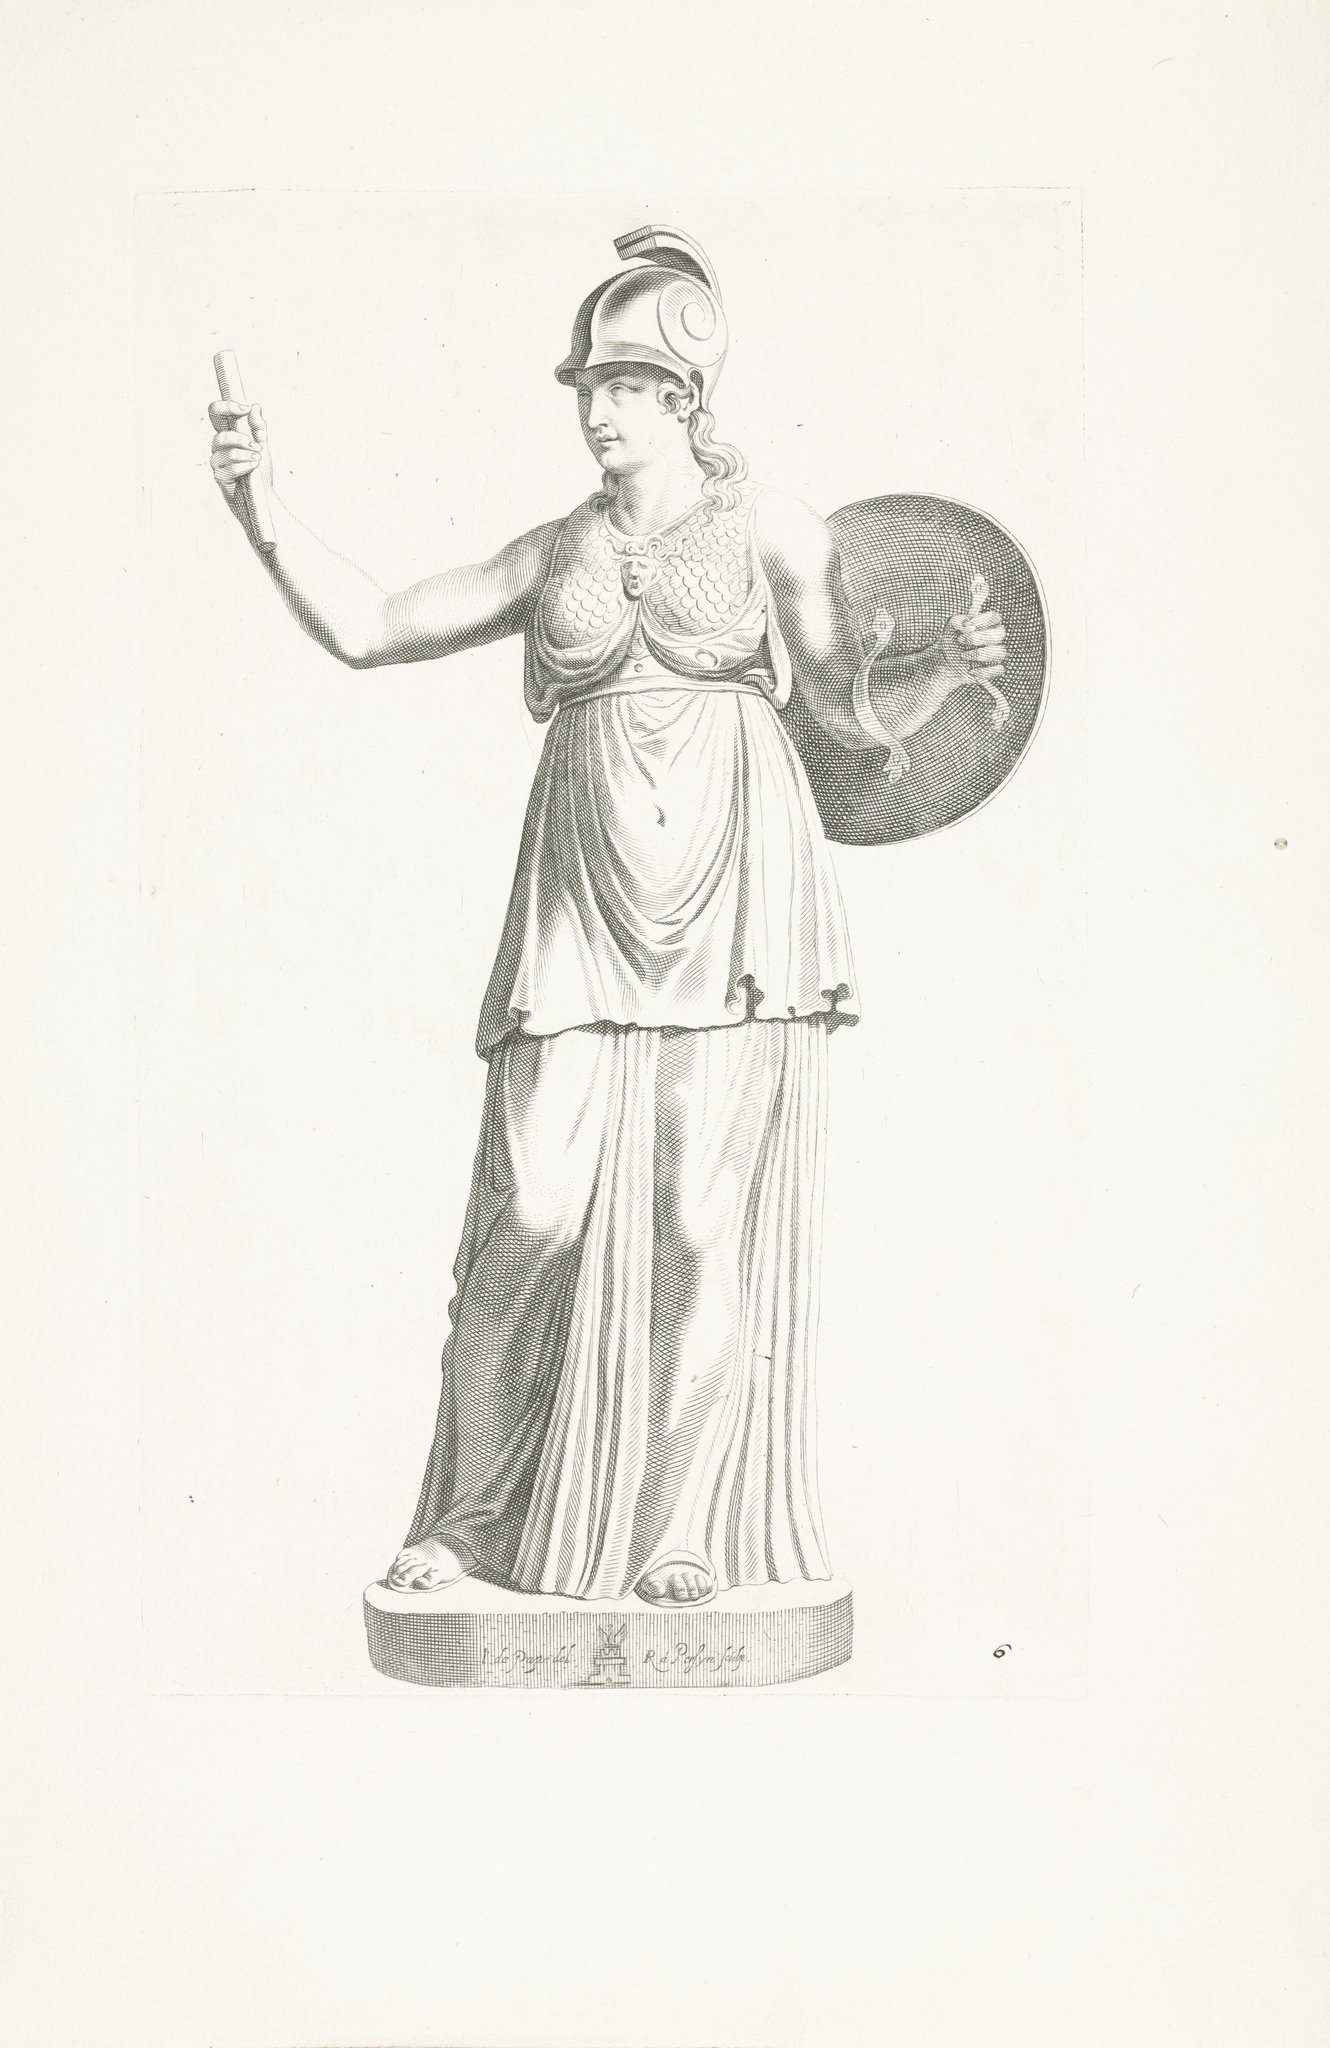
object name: print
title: Standbeeld van Minerva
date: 1640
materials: paper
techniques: engraving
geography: rome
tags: rome, vincenzo giustiniani (1564-1637), (story of) minerva (pallas, athena), piece of sculpture, reproduction of a piece of sculpture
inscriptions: collector's mark: Lugt 2228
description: Standbeeld van Minerva, in klassiek gewaad, met een commandostaf en schild in de handen. Midden onder op de basis het wapenschild van Vincenzo Giustiniani. Prent uit een publicatie met reproductieprenten naar de sculpturen in de verzameling in de Galleria Giustiniani te Rome.